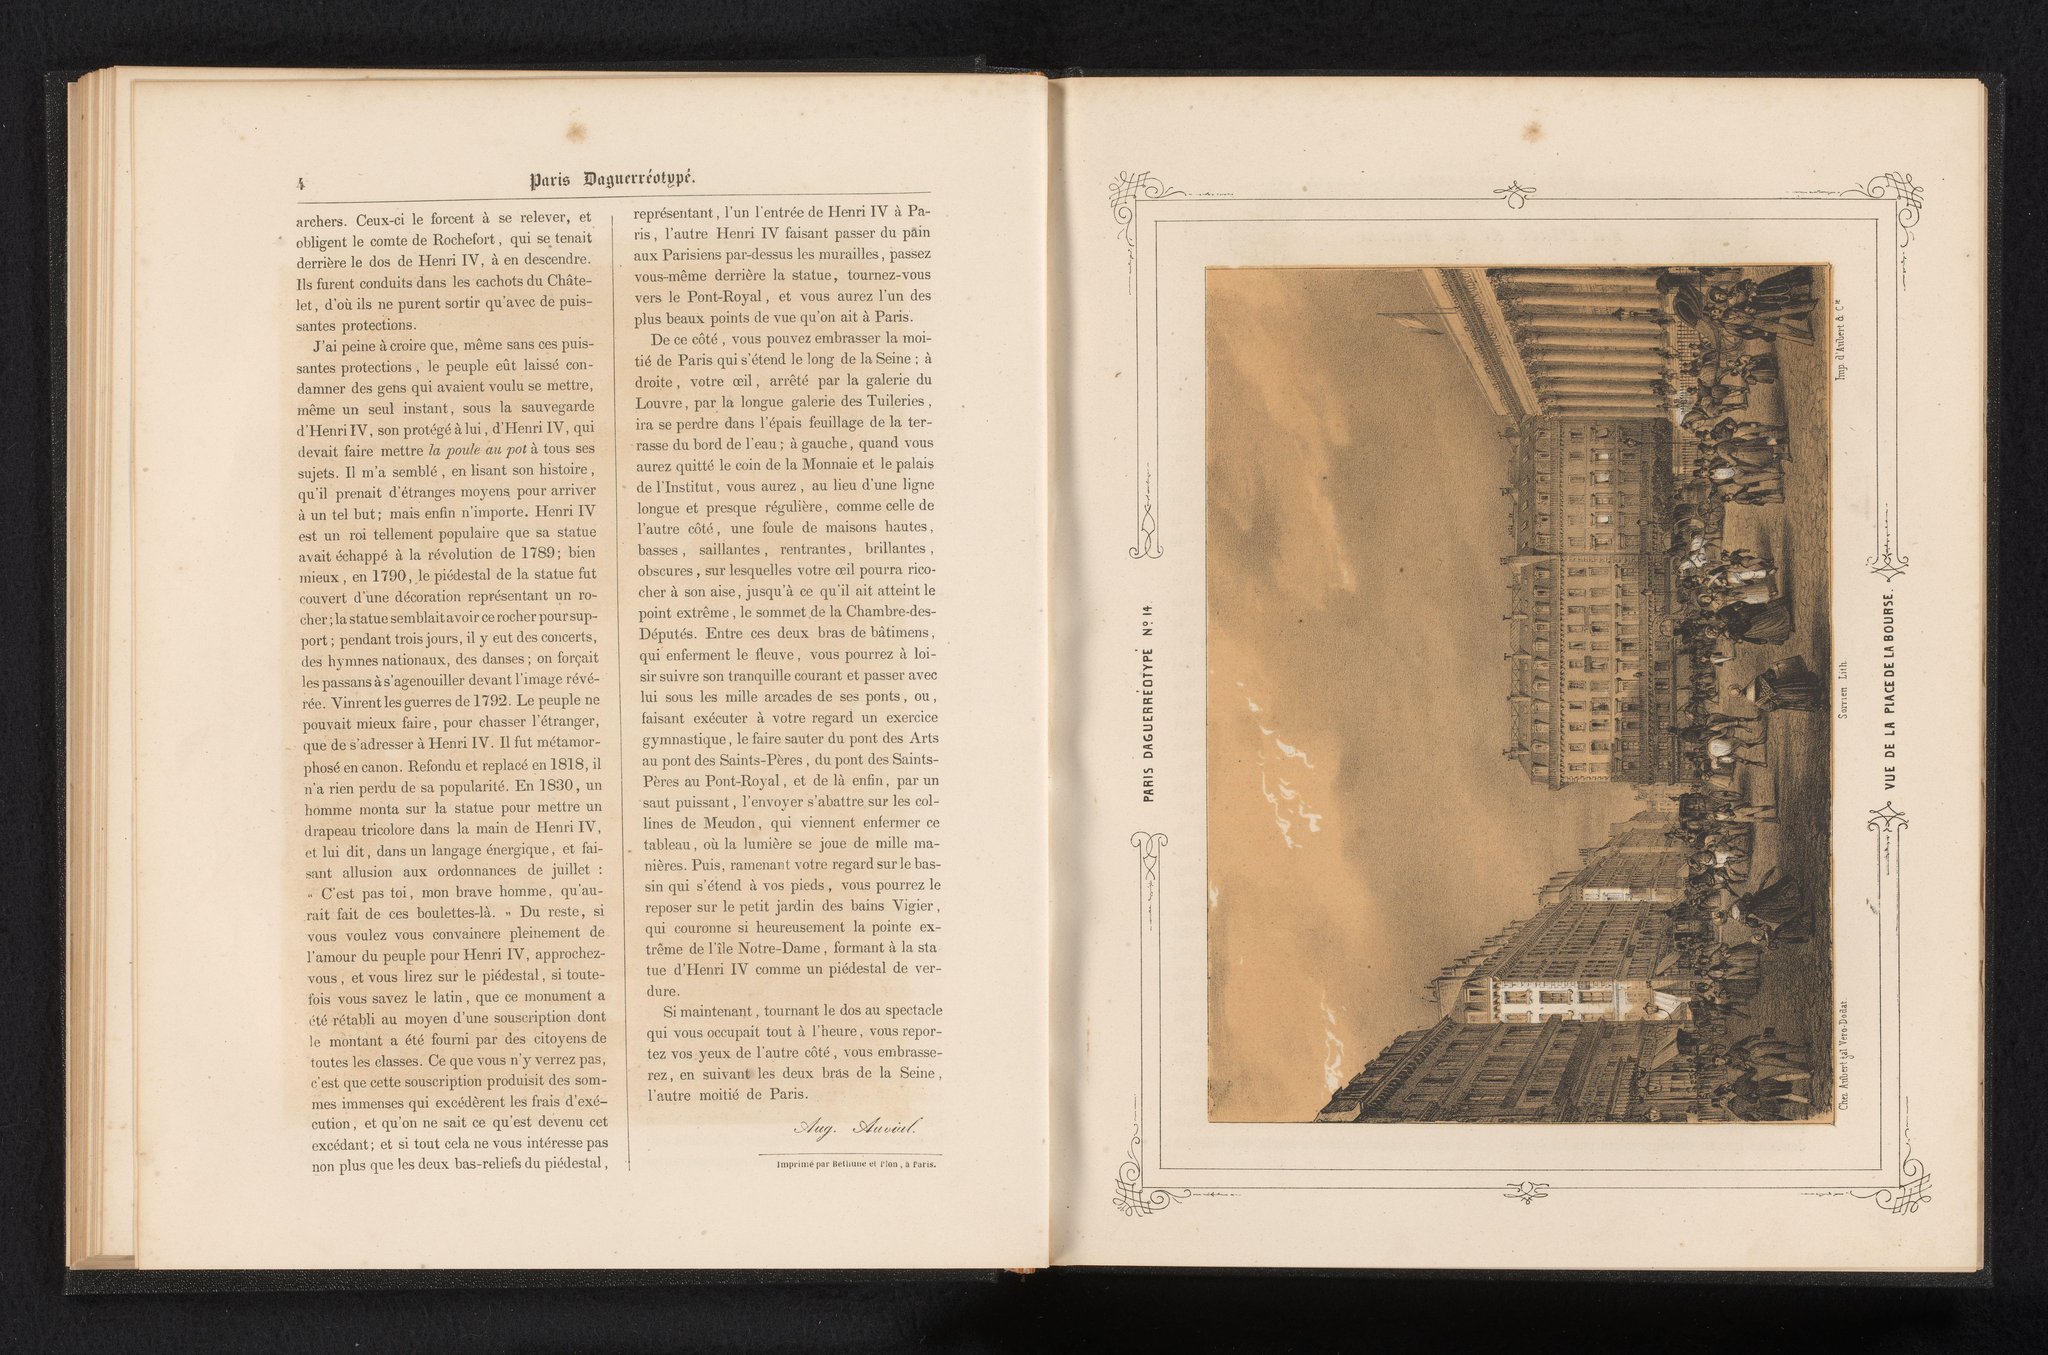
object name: page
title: Vue de la Place de la Bourse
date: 1839-1840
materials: paper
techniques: tone lithography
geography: paris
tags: square, place, circus, etc., paris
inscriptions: inscription: ‘PARIS DAGUERRÉOTYPÉ No. 14.’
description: Prent op drieënvijftigste ongenummerde pagina.